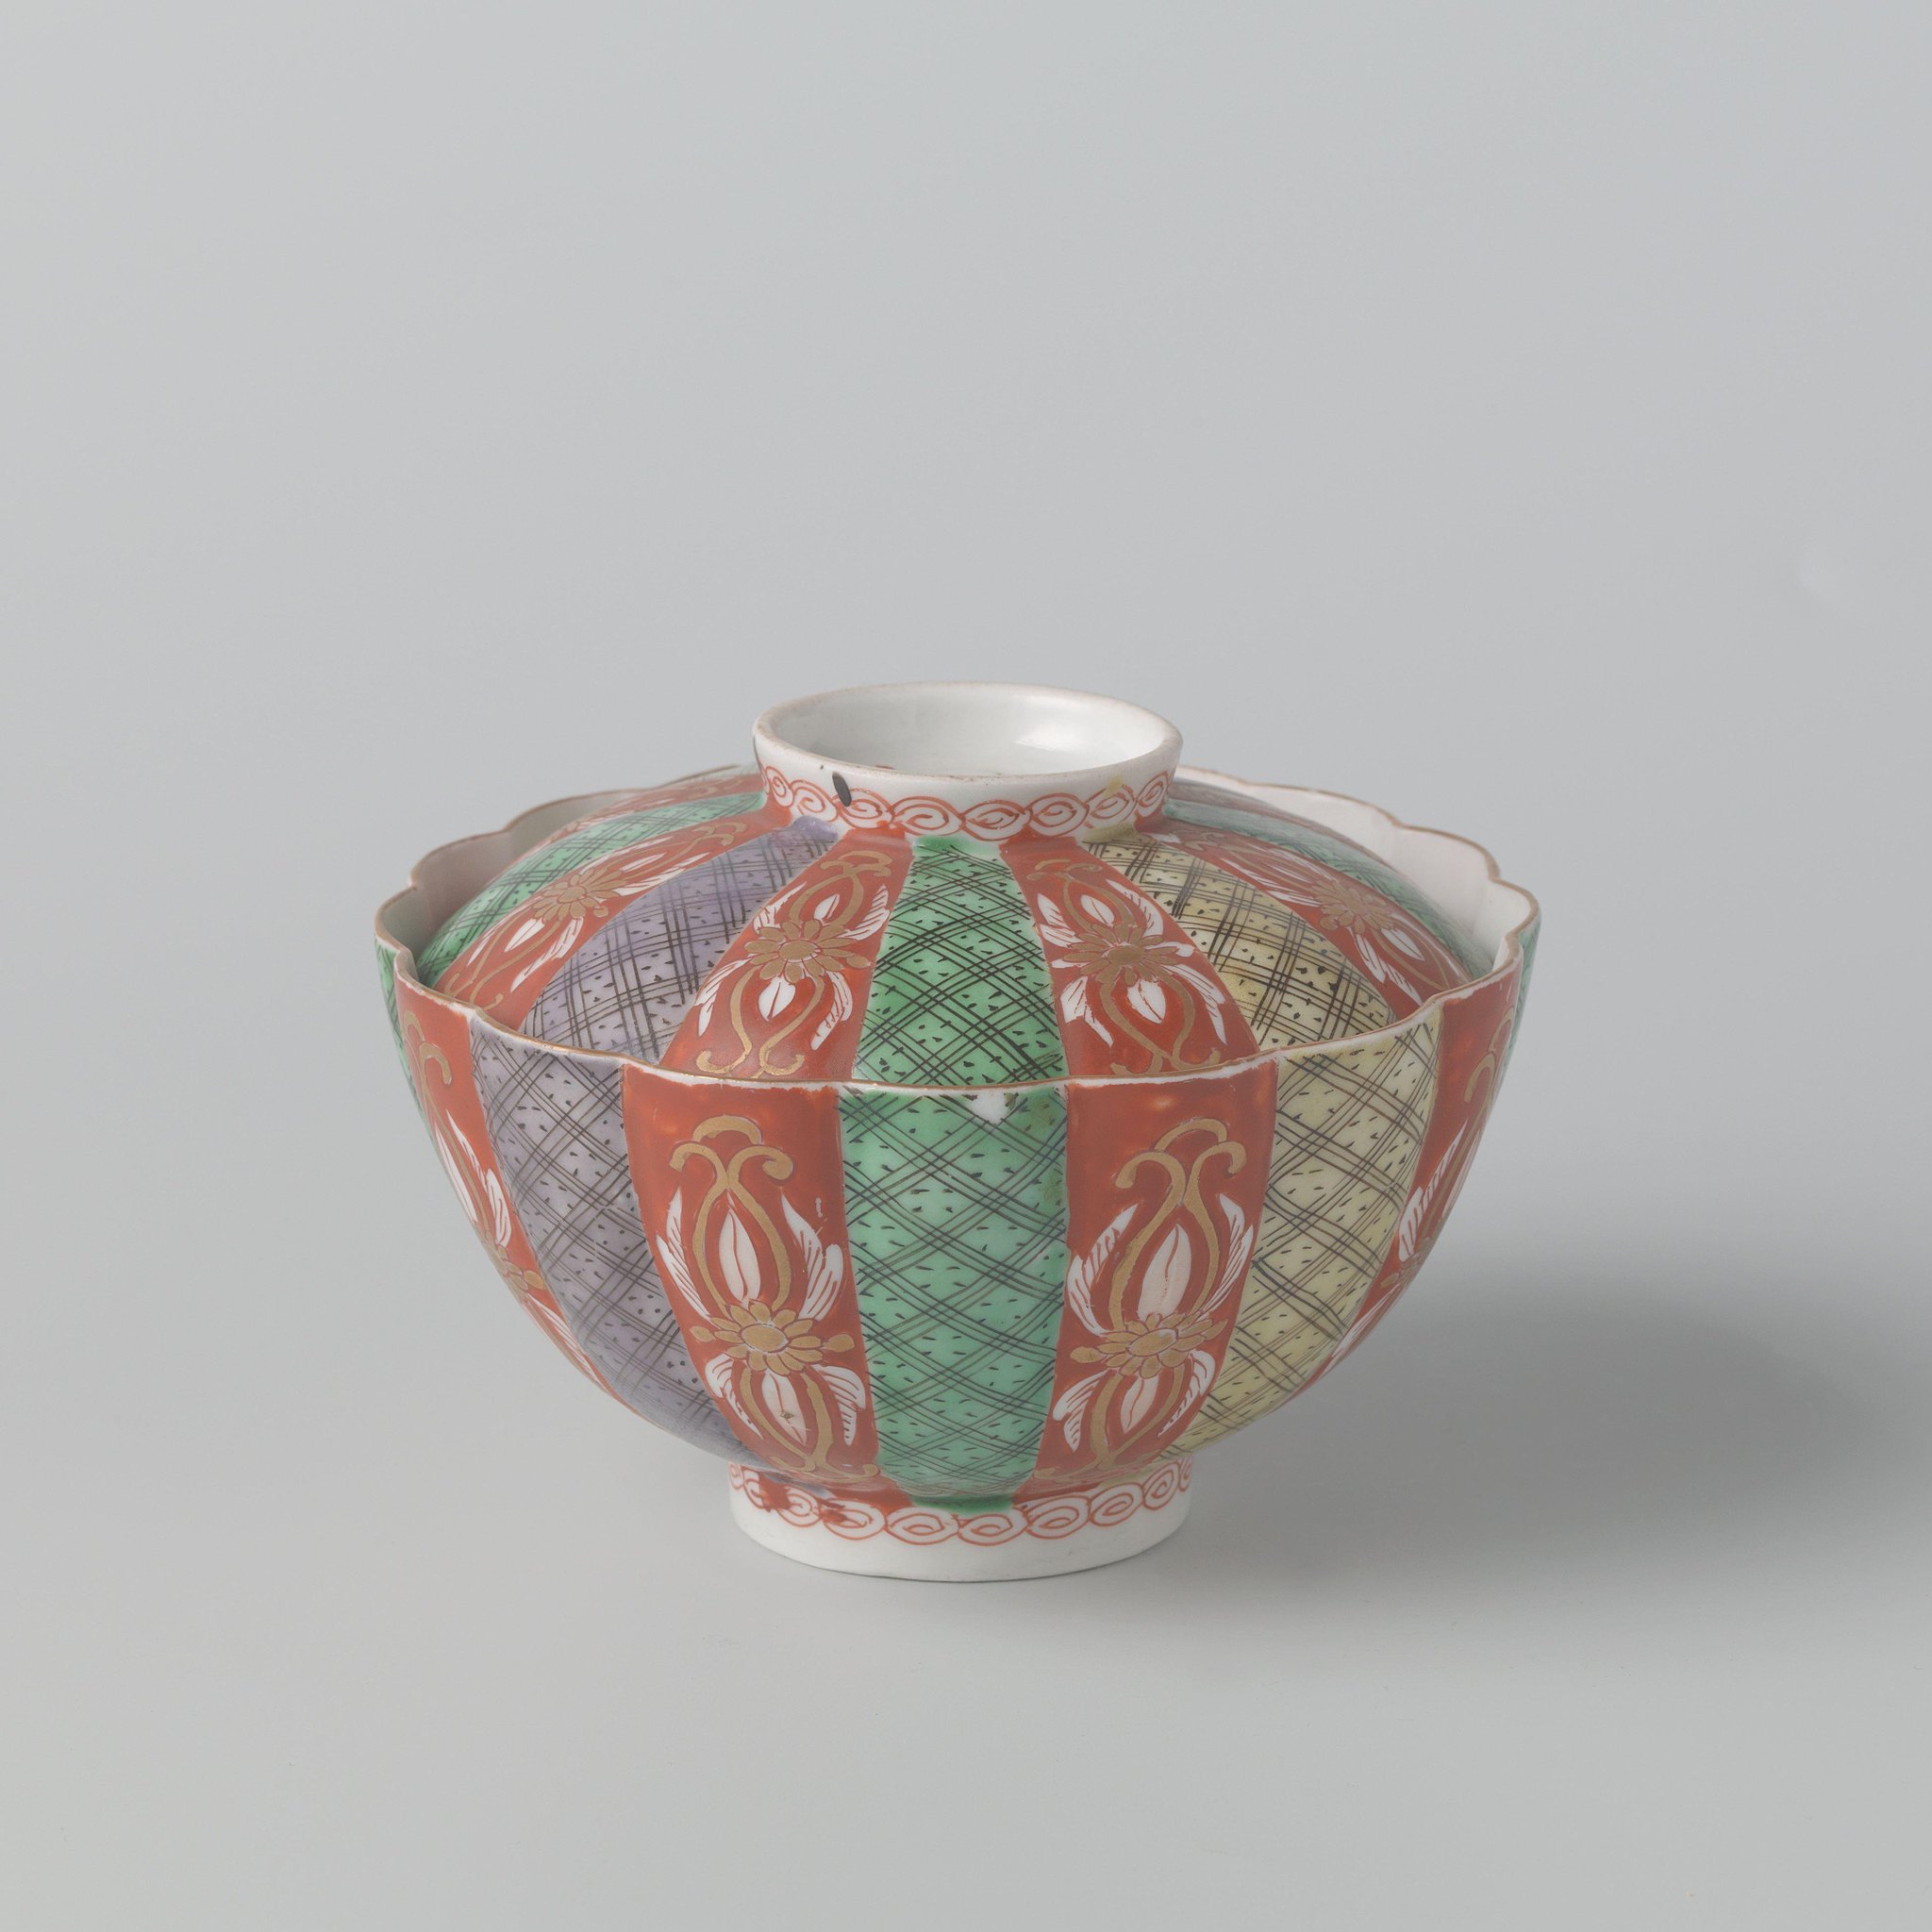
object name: bowl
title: Covered bowl with scrolls, diaper pattern and scattered flowers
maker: Anonymous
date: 1700-1749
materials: glaze, gold, porcelain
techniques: firing, gilding, turning, vitrification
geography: japan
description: Kom met deksel, met geribde wand en rand. Beschilderd in emailkleuren met velden met geometrische patronen en ranken tegen een rode, groene, gele en aubergine-kleurige achtergrond. Aan de binne zijde gestileerde chrysanten.